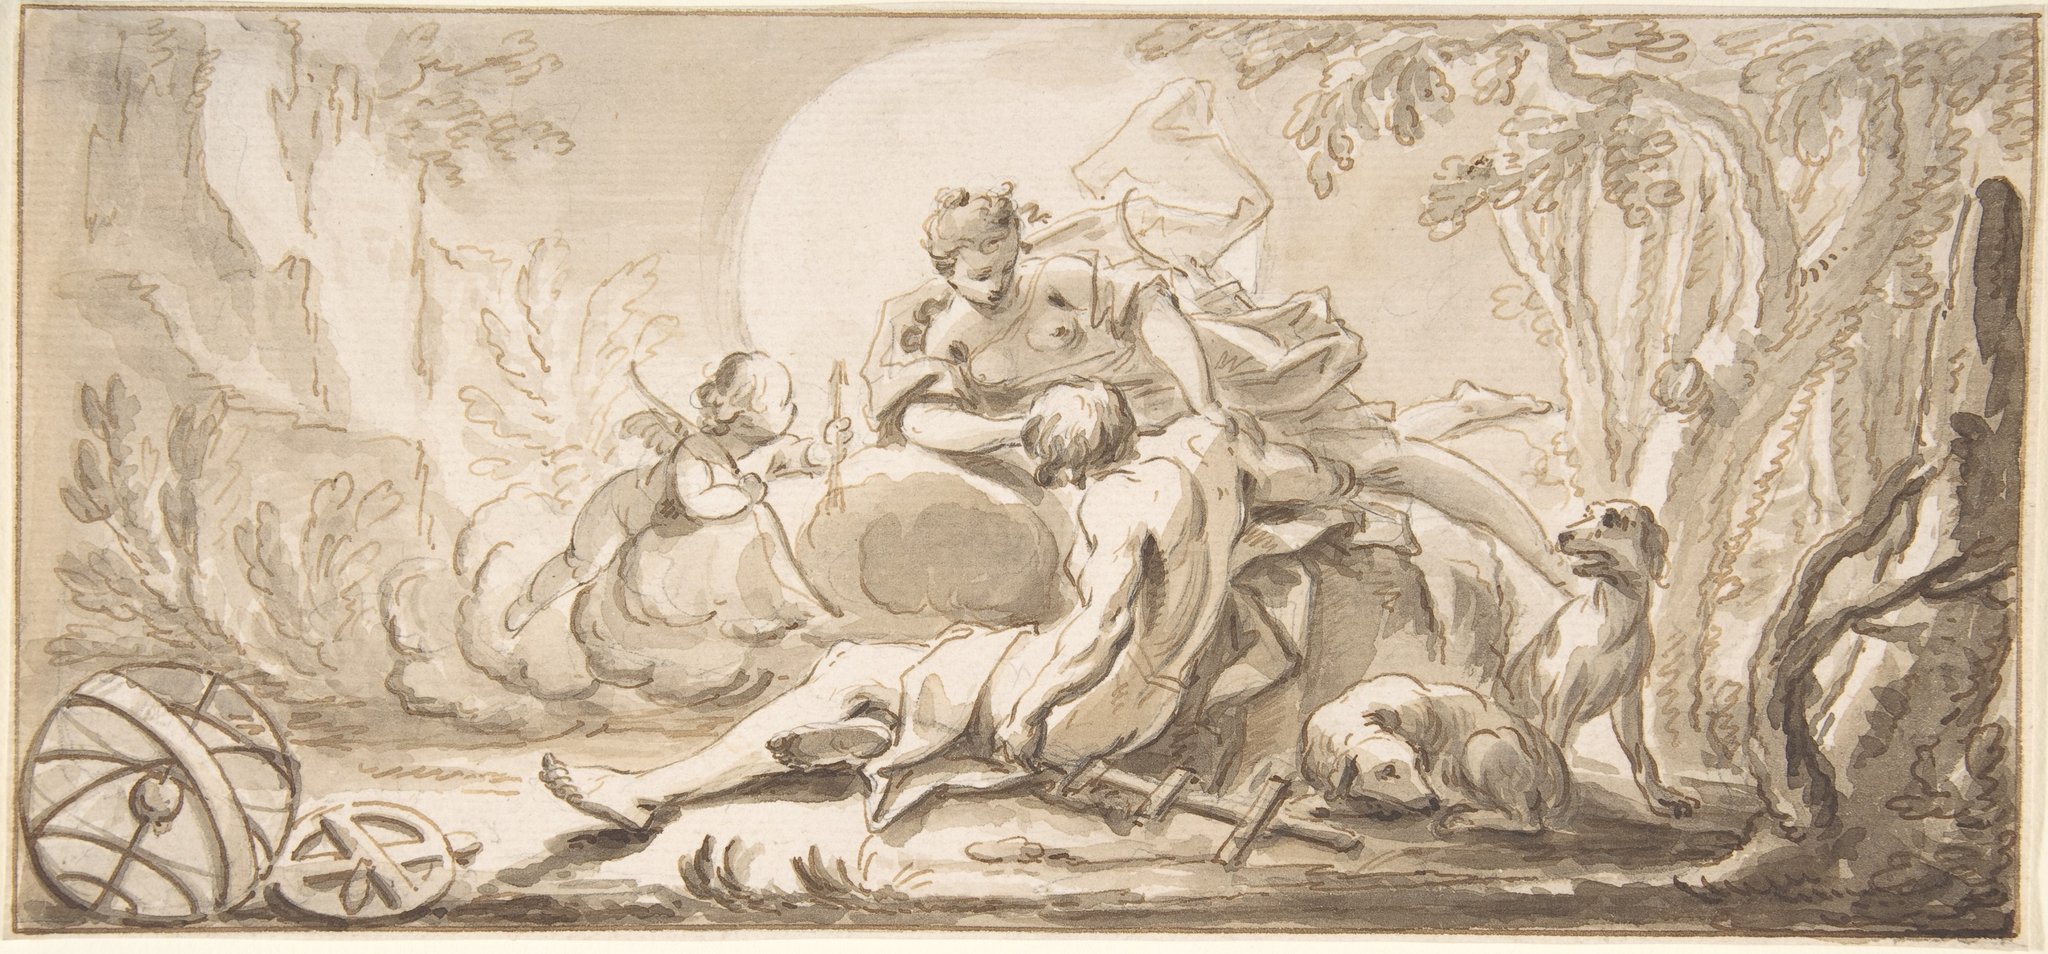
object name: drawing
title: Diana and Endymion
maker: johann heinrich keller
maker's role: artist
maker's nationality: swiss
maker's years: 1692-1765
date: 1700-1765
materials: ink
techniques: brush, pen, wash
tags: animals,swords,men,cupid,diana